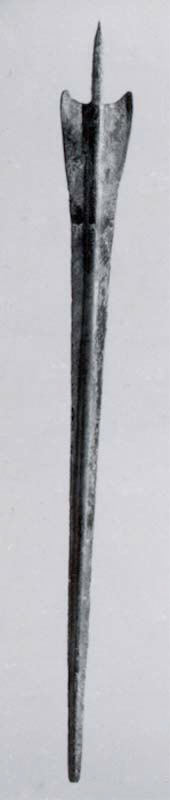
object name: spearhead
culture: iranian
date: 800-601 BCE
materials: bronze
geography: northwestern iran, caspian region